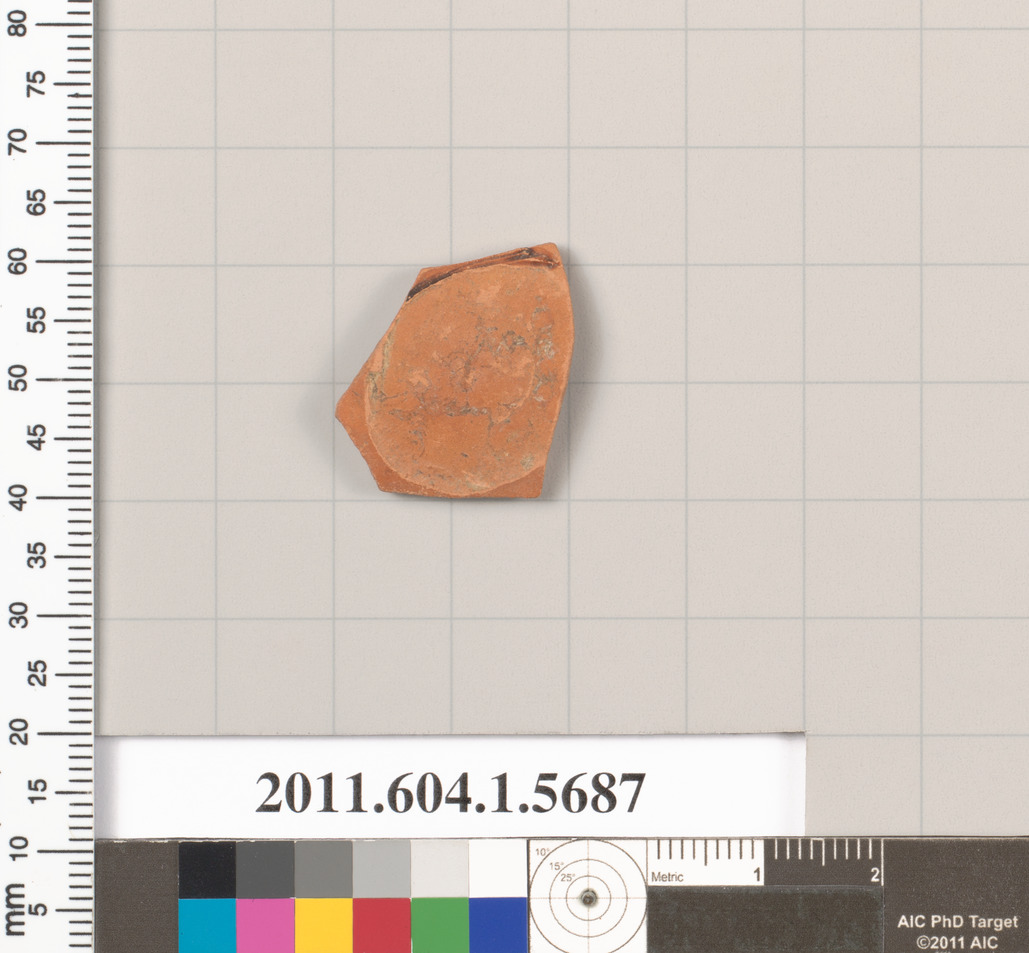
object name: kylix fragment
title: Terracotta fragment of a kylix (drinking cup)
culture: greek, attic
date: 520-480 BCE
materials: terracotta